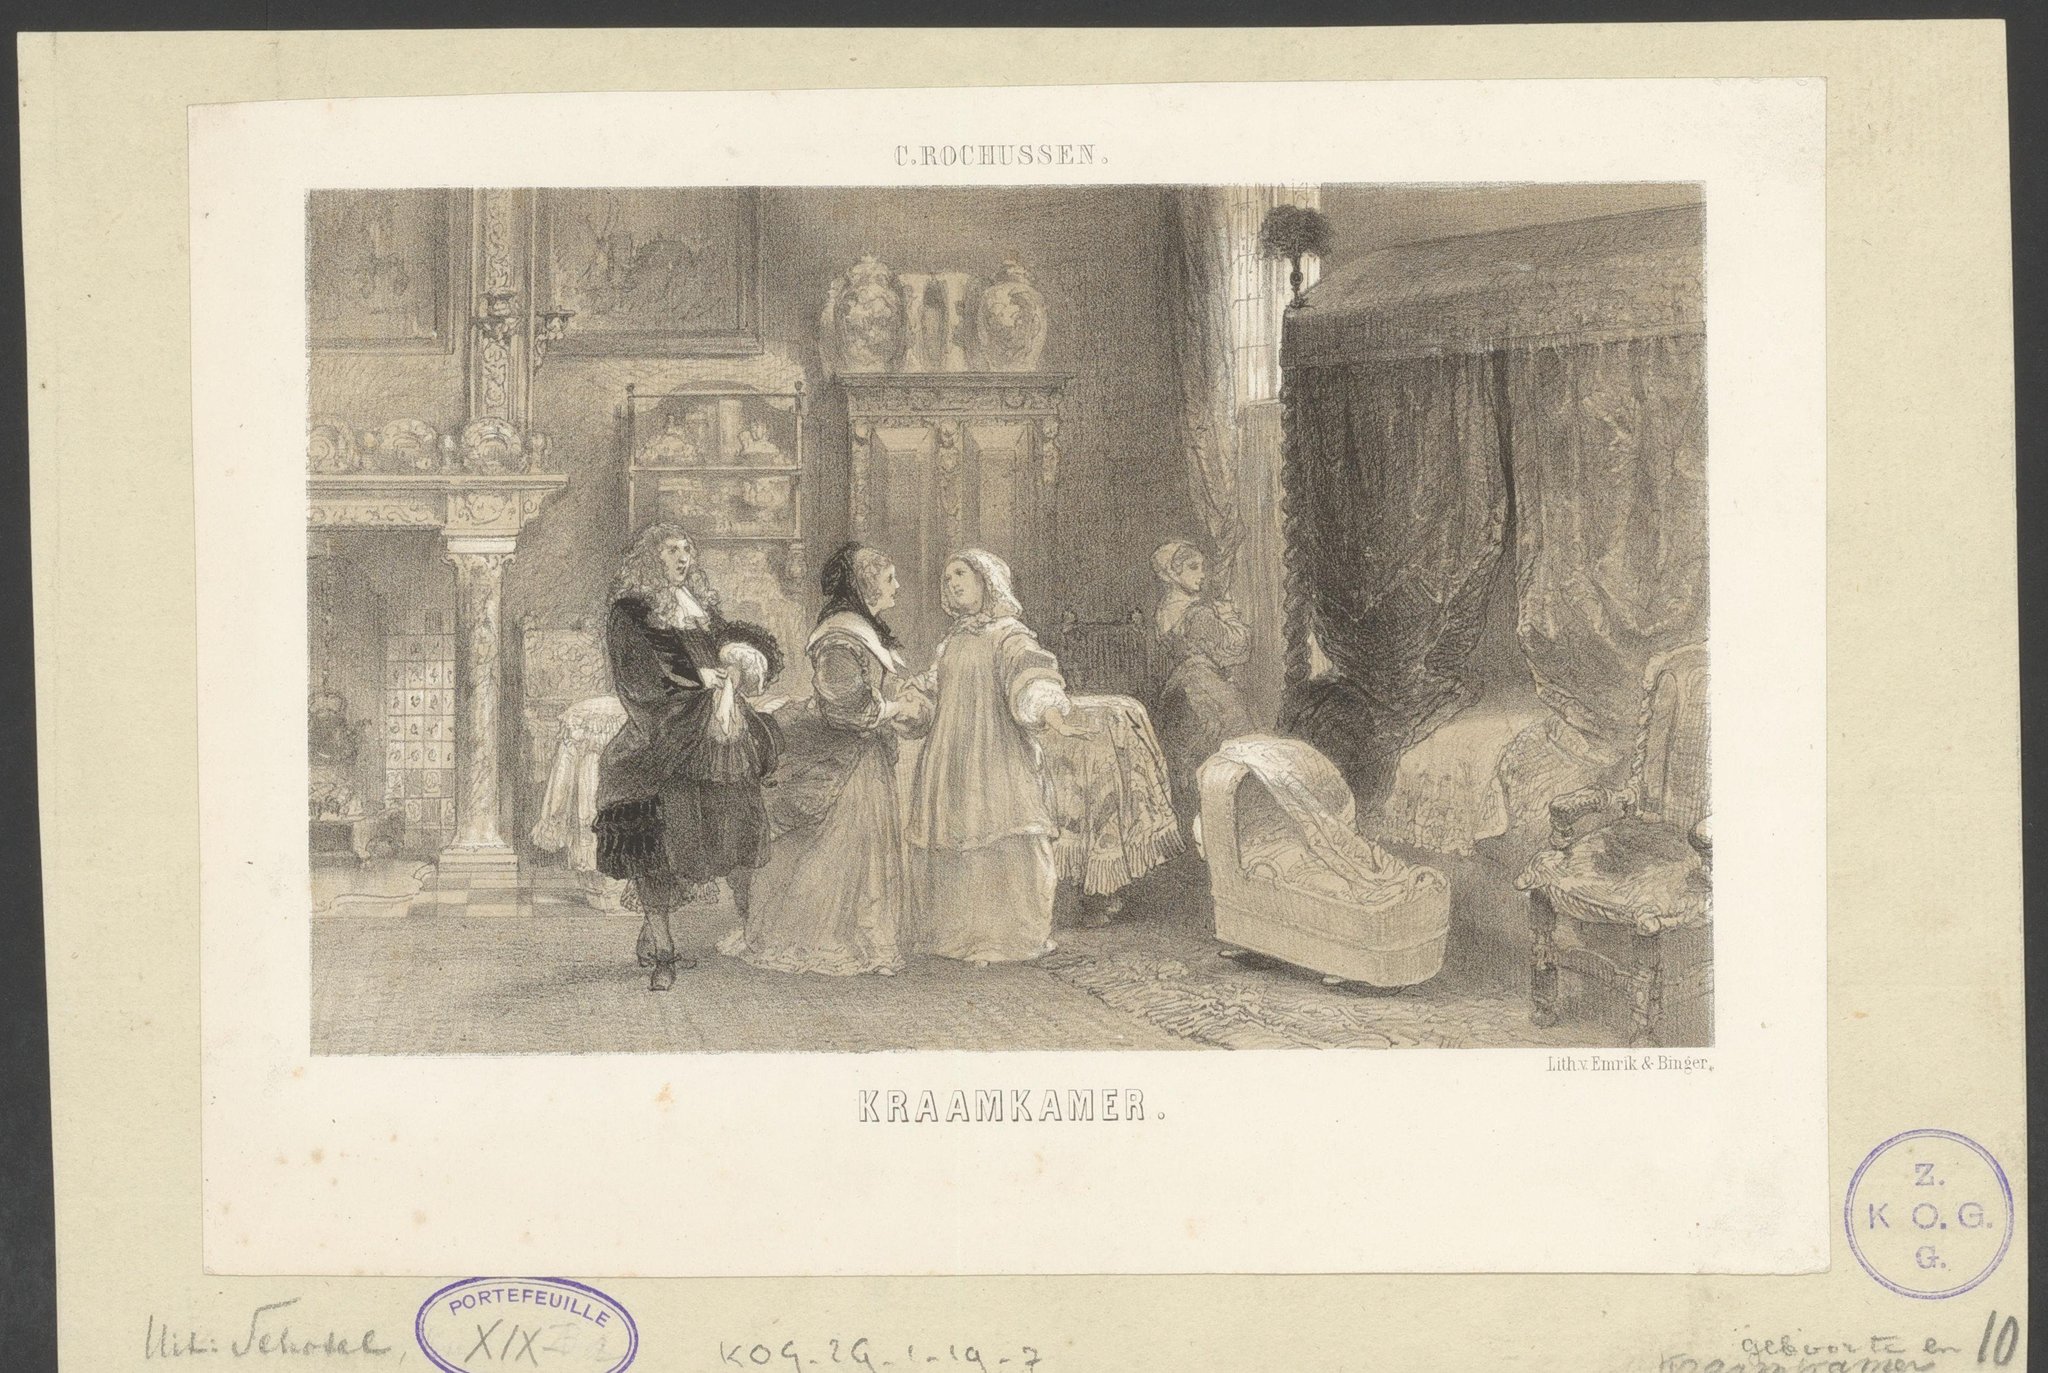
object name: print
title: Kraamkamer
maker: arie cornelis kruseman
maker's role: bookseller, printer, publisher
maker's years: 1818-1894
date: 1867-1868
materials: paper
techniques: tone lithography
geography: haarlem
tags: visiting the new mother, lying-in visit, lying-in room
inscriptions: collector's mark:, collector's mark: Lugt 1641, collector's mark: Lugt 1641a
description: Drie vrouwen en een man in een kamer met links een haard, rechts een bed en een wieg. Onderwerpsrubrieken binnen de Atlas Zeden en Gewoonten: Des Menschen Begin, Midden en Einde. Geboorte en kraamkamer.